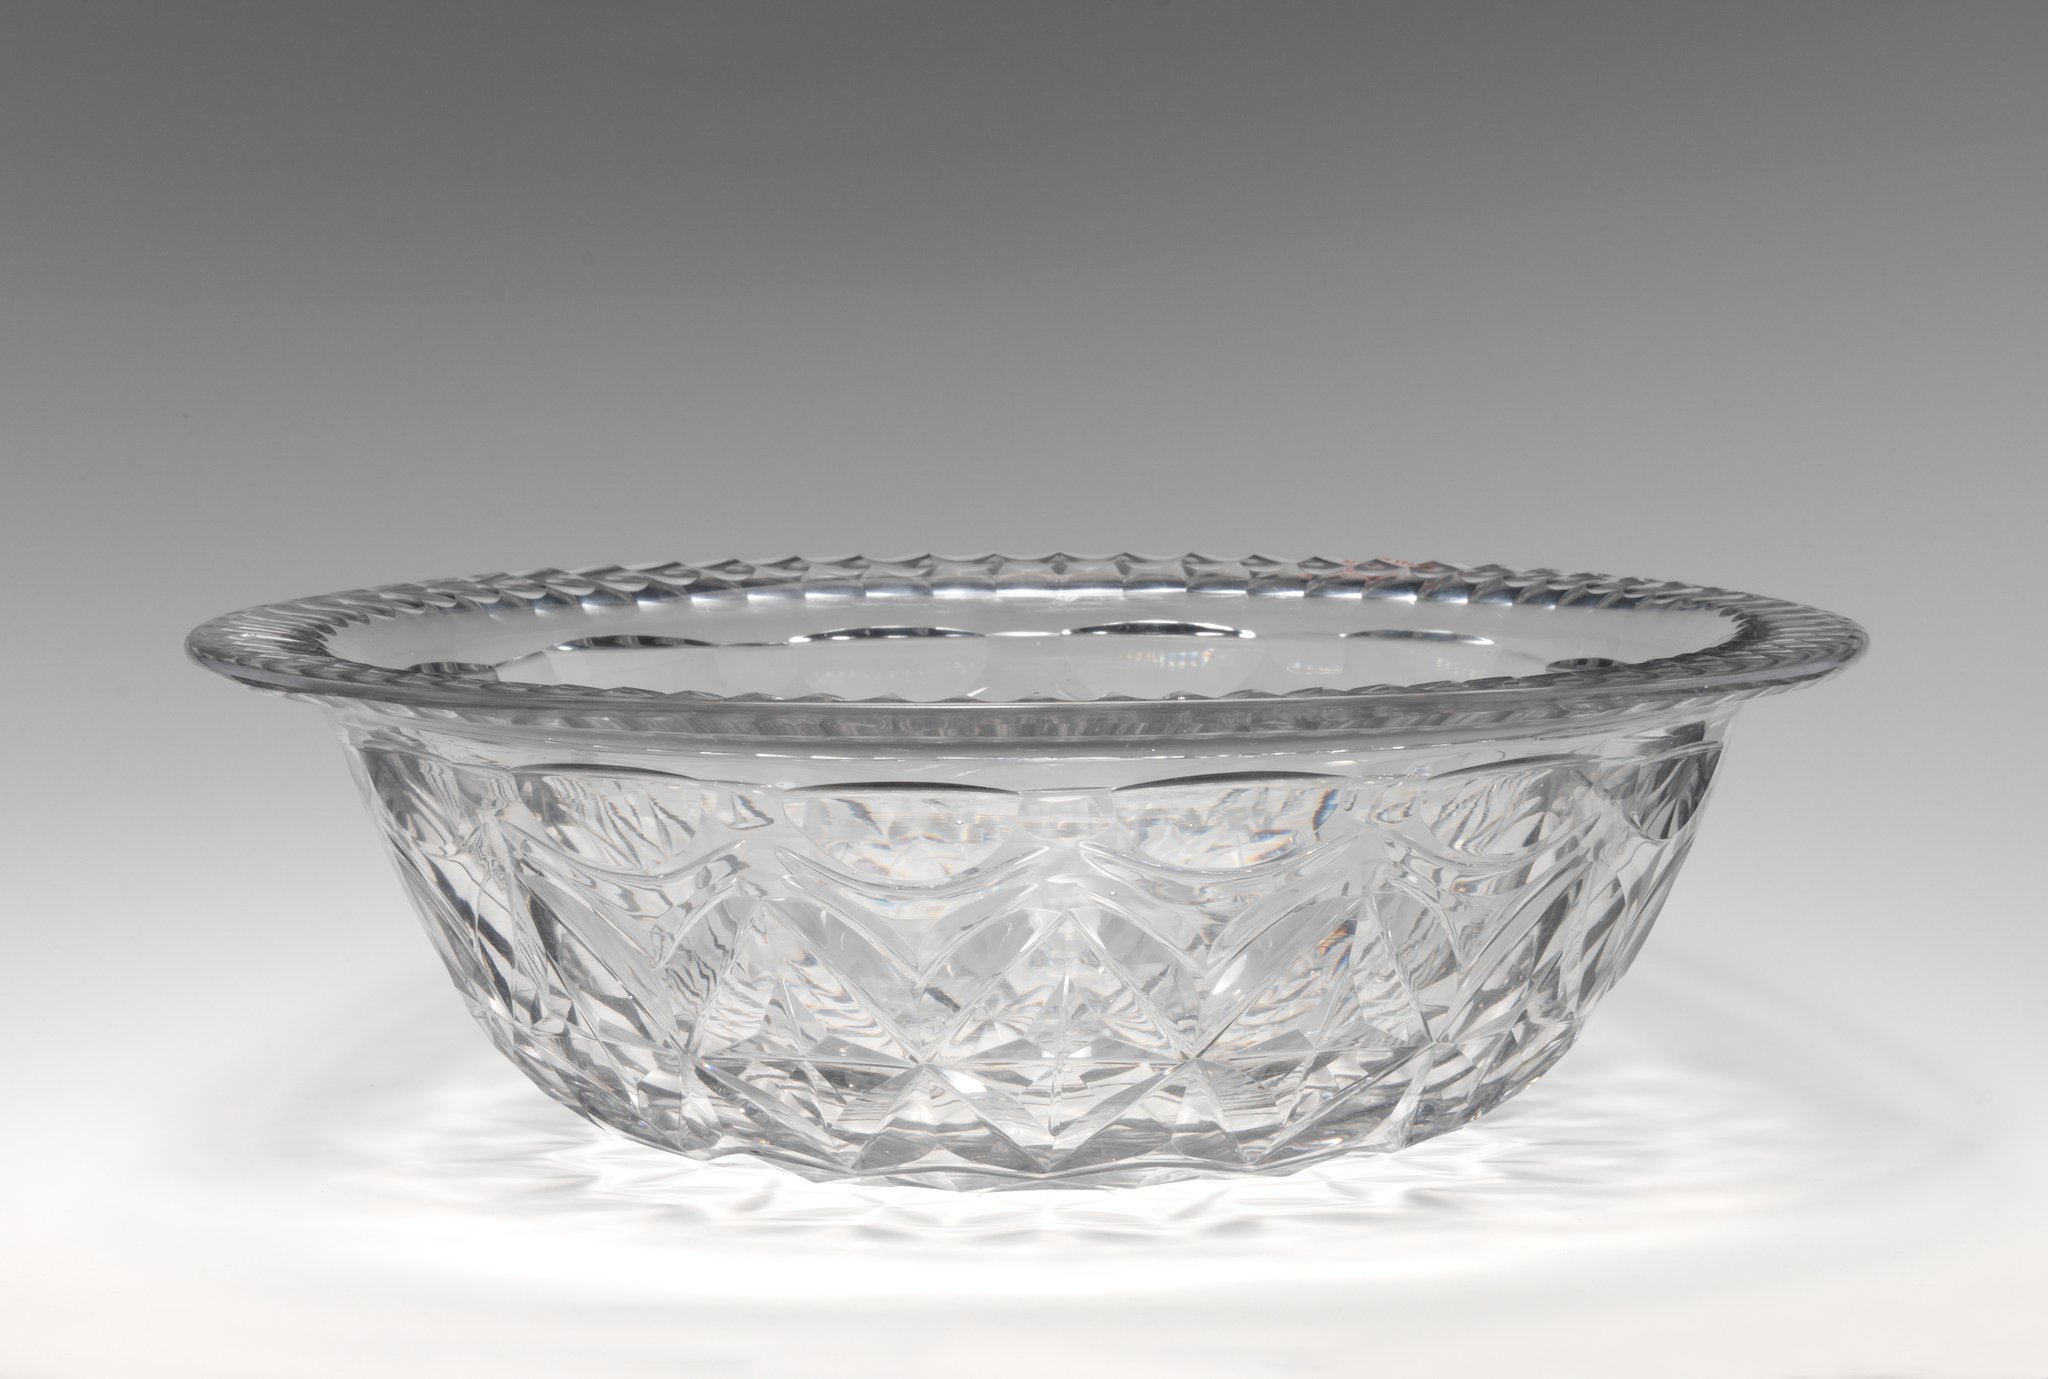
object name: bowl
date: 1801-1833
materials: glass